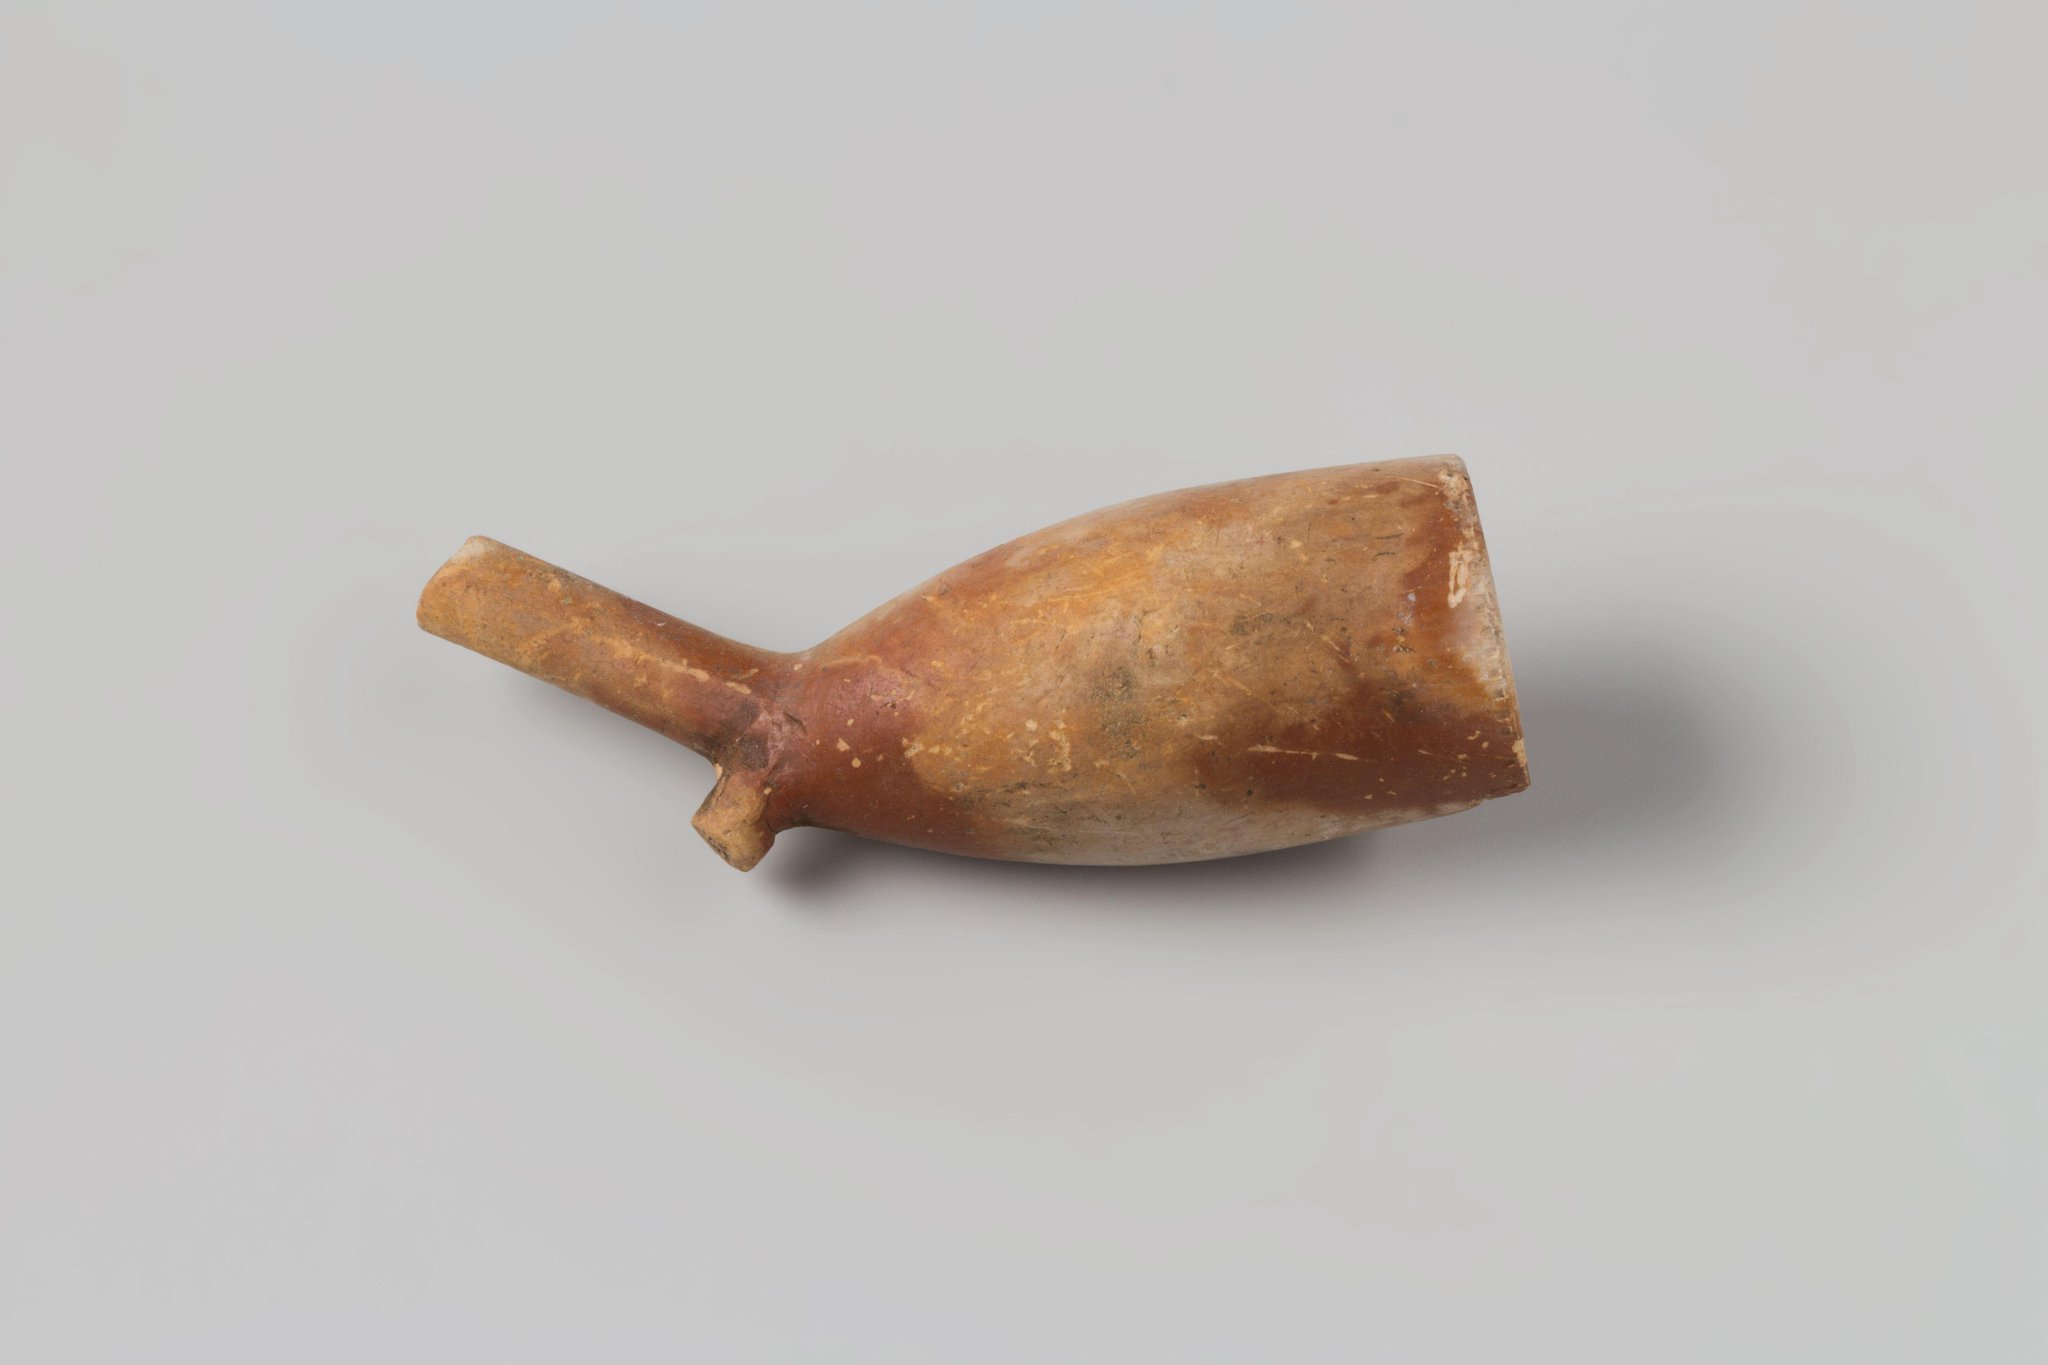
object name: pipe bowl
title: Fragment pijpenkop met stuk steel uit het wrak van de Oost-Indiëvaarder Hollandia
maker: Anonymous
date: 1700-1743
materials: clay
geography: netherlands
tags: verenigde oostindische compagnie, hollandia (schip), annet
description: Pipe, bowl, heelmark: crowned 47; fragment, 2hsm3.